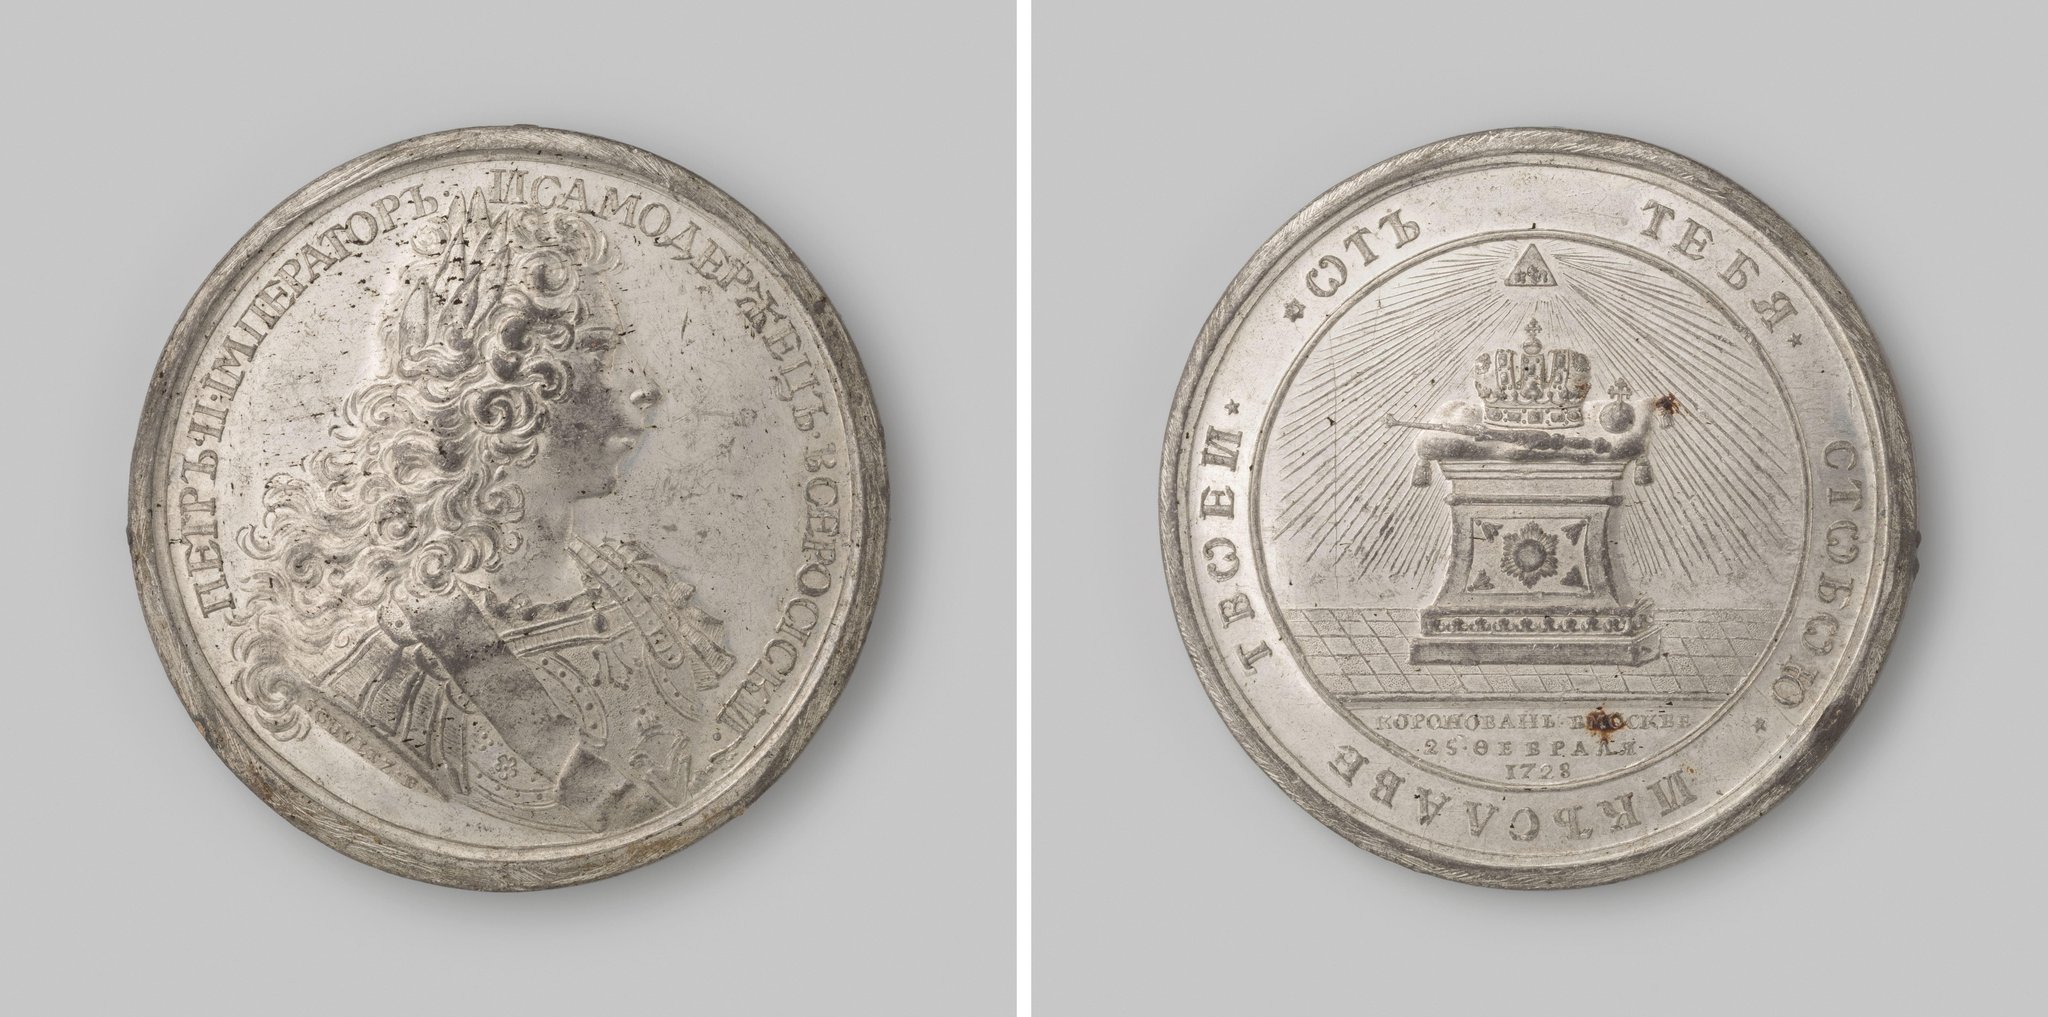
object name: history medal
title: Kroning van Tsaar Peter II te Moskou 1728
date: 1728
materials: tin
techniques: striking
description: Tinnen penning, op de voorzijde het borstbeeld van Tsaar Peter II naar rechts met omschrift, op de keerzijde een altaar waarop kroon, globe en scepter onder het stralende oog Gods, met afsnedetekst en omschrift.